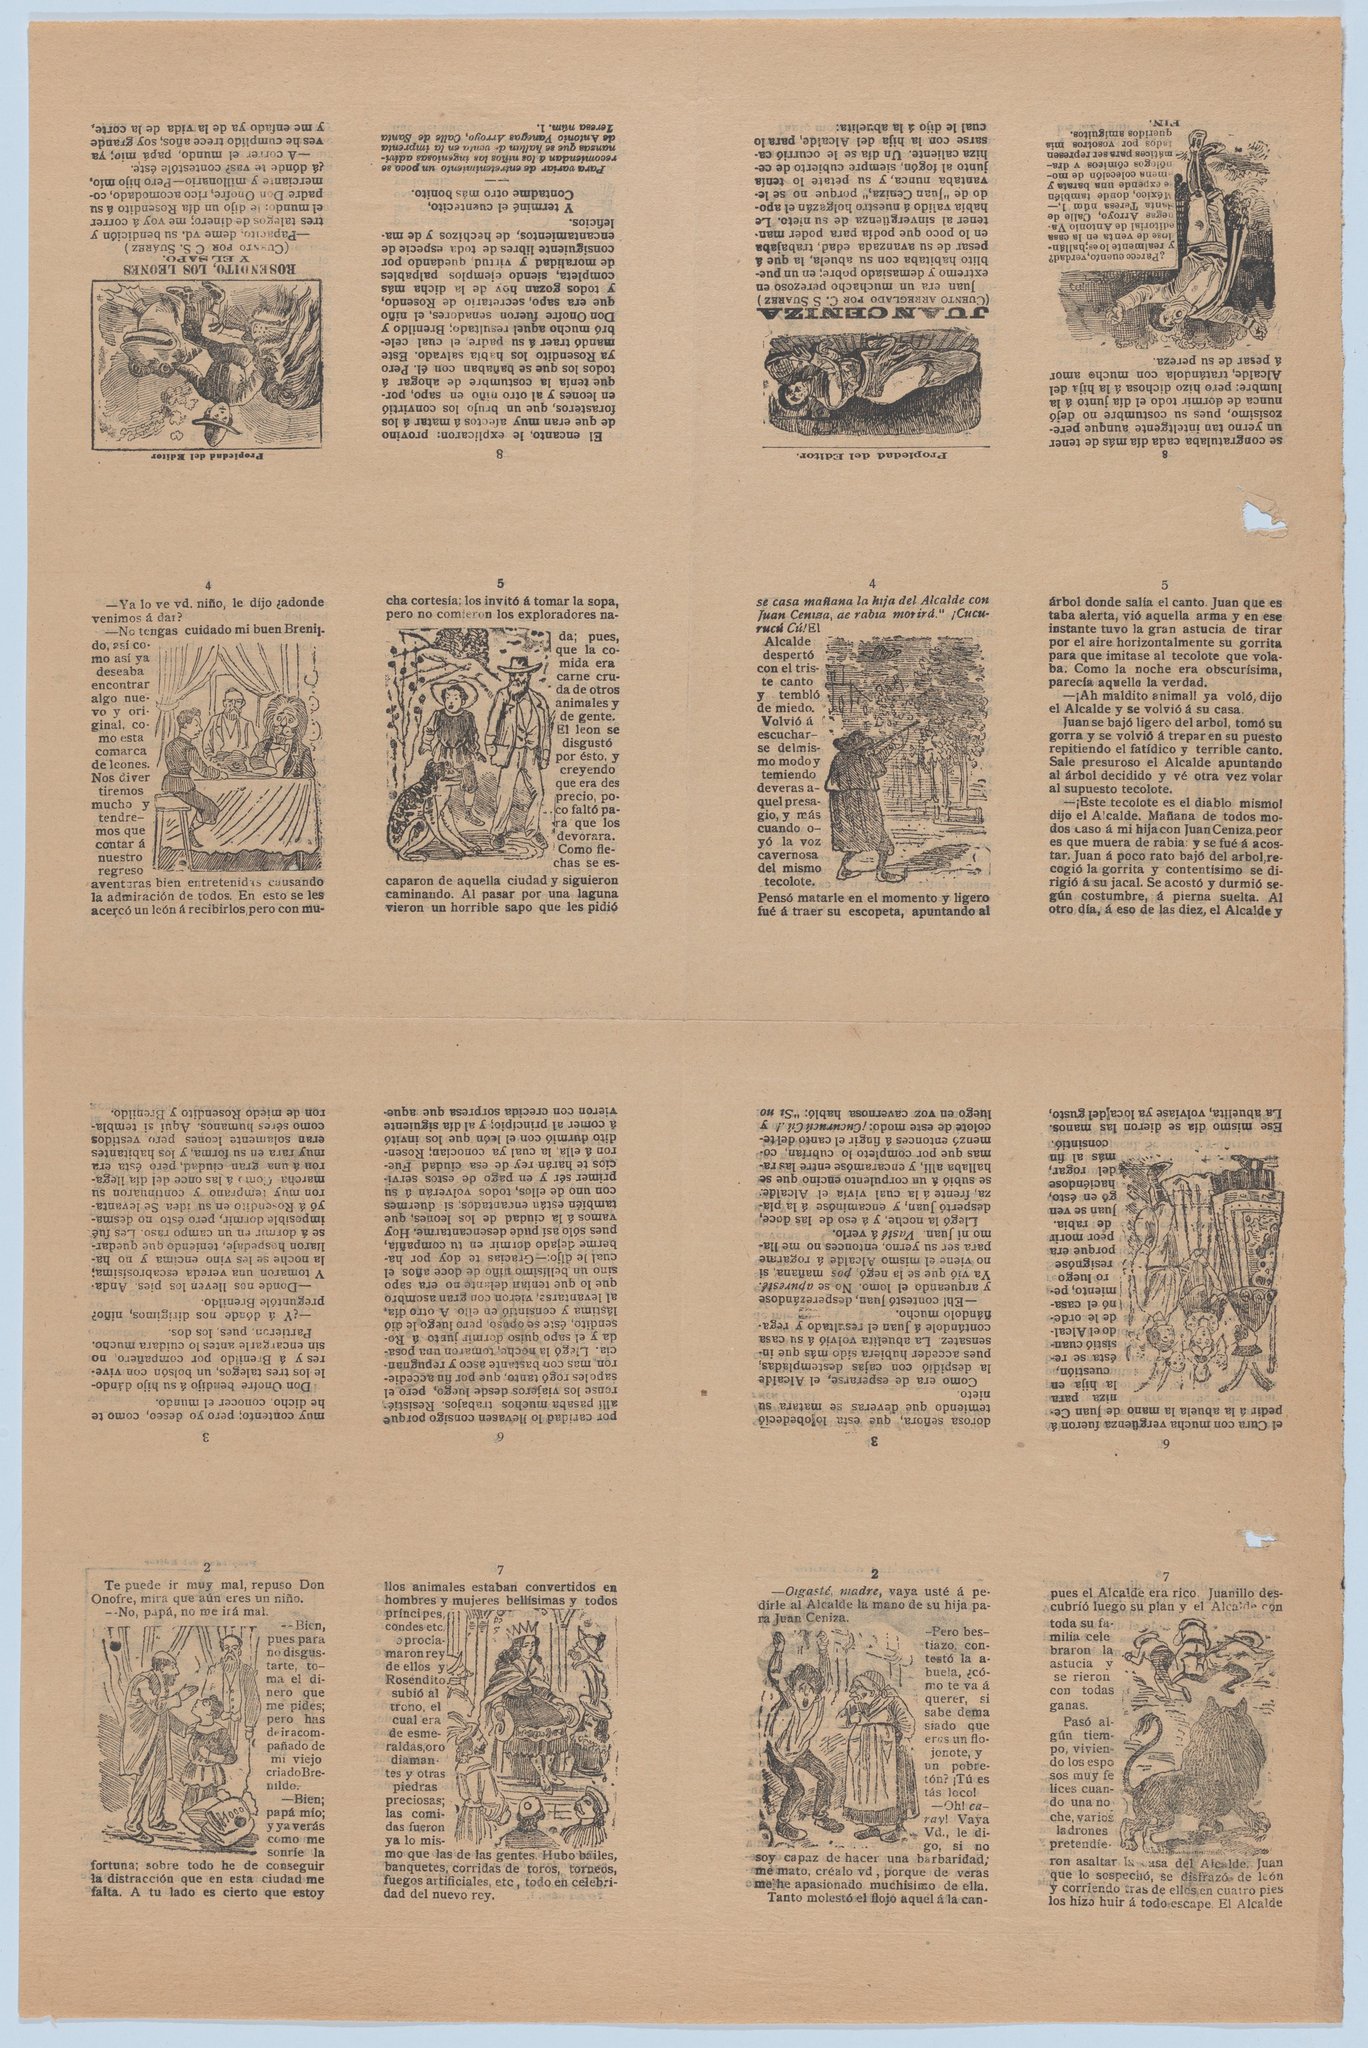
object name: print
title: An uncut sheet printed on both sides with pages from "Juan Ceniza" (cuento arreglado por C. S. Suarez) and "Rosendito, los leones y el sapo" (cuento por C. S. Suarez)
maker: josé guadalupe posada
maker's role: artist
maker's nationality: mexican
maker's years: 1852-1913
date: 1900-1910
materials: zinc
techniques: etching, letterpress, relief print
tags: animals,men,women